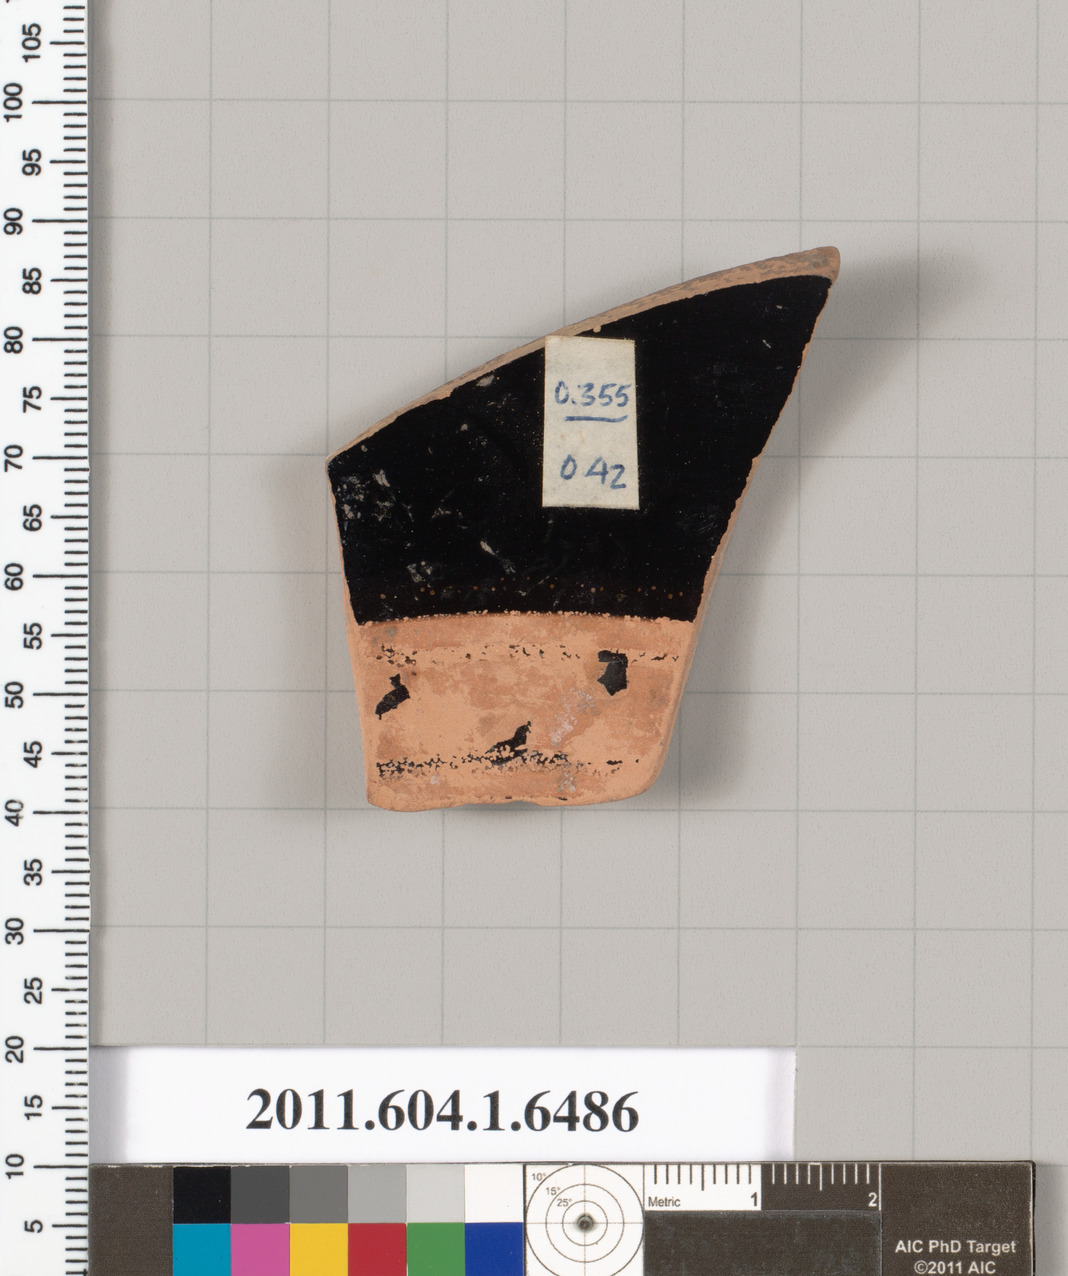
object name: kylix fragment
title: Terracotta fragment of a kylix (drinking cup)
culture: greek, attic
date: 490-480 BCE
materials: terracotta